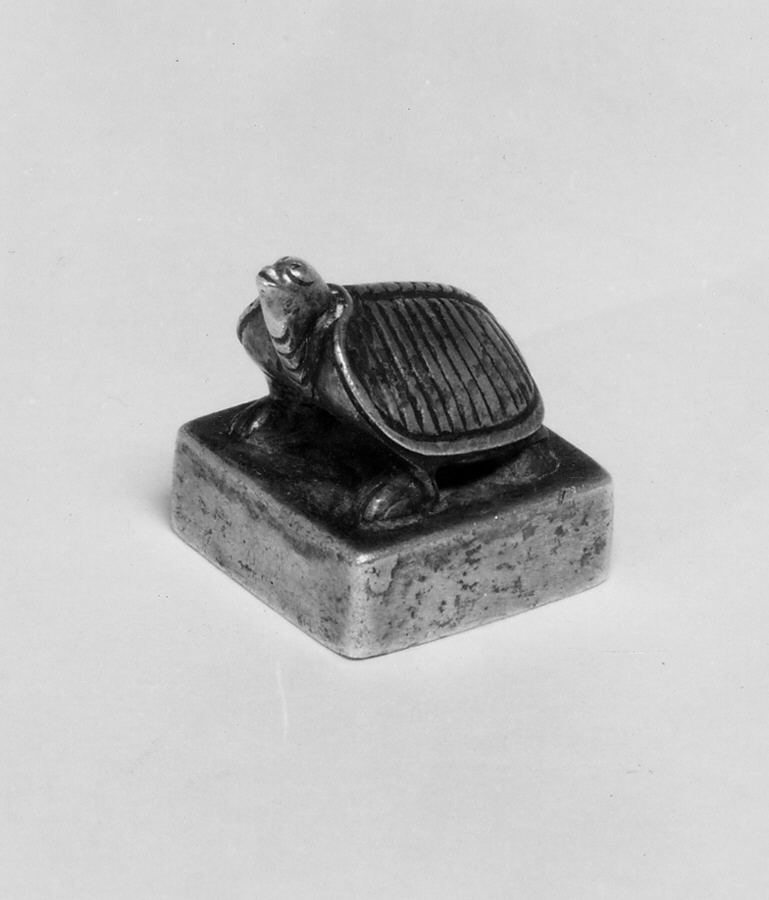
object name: seal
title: 周順昌印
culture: chinese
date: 1600-1625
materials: silver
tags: turtles